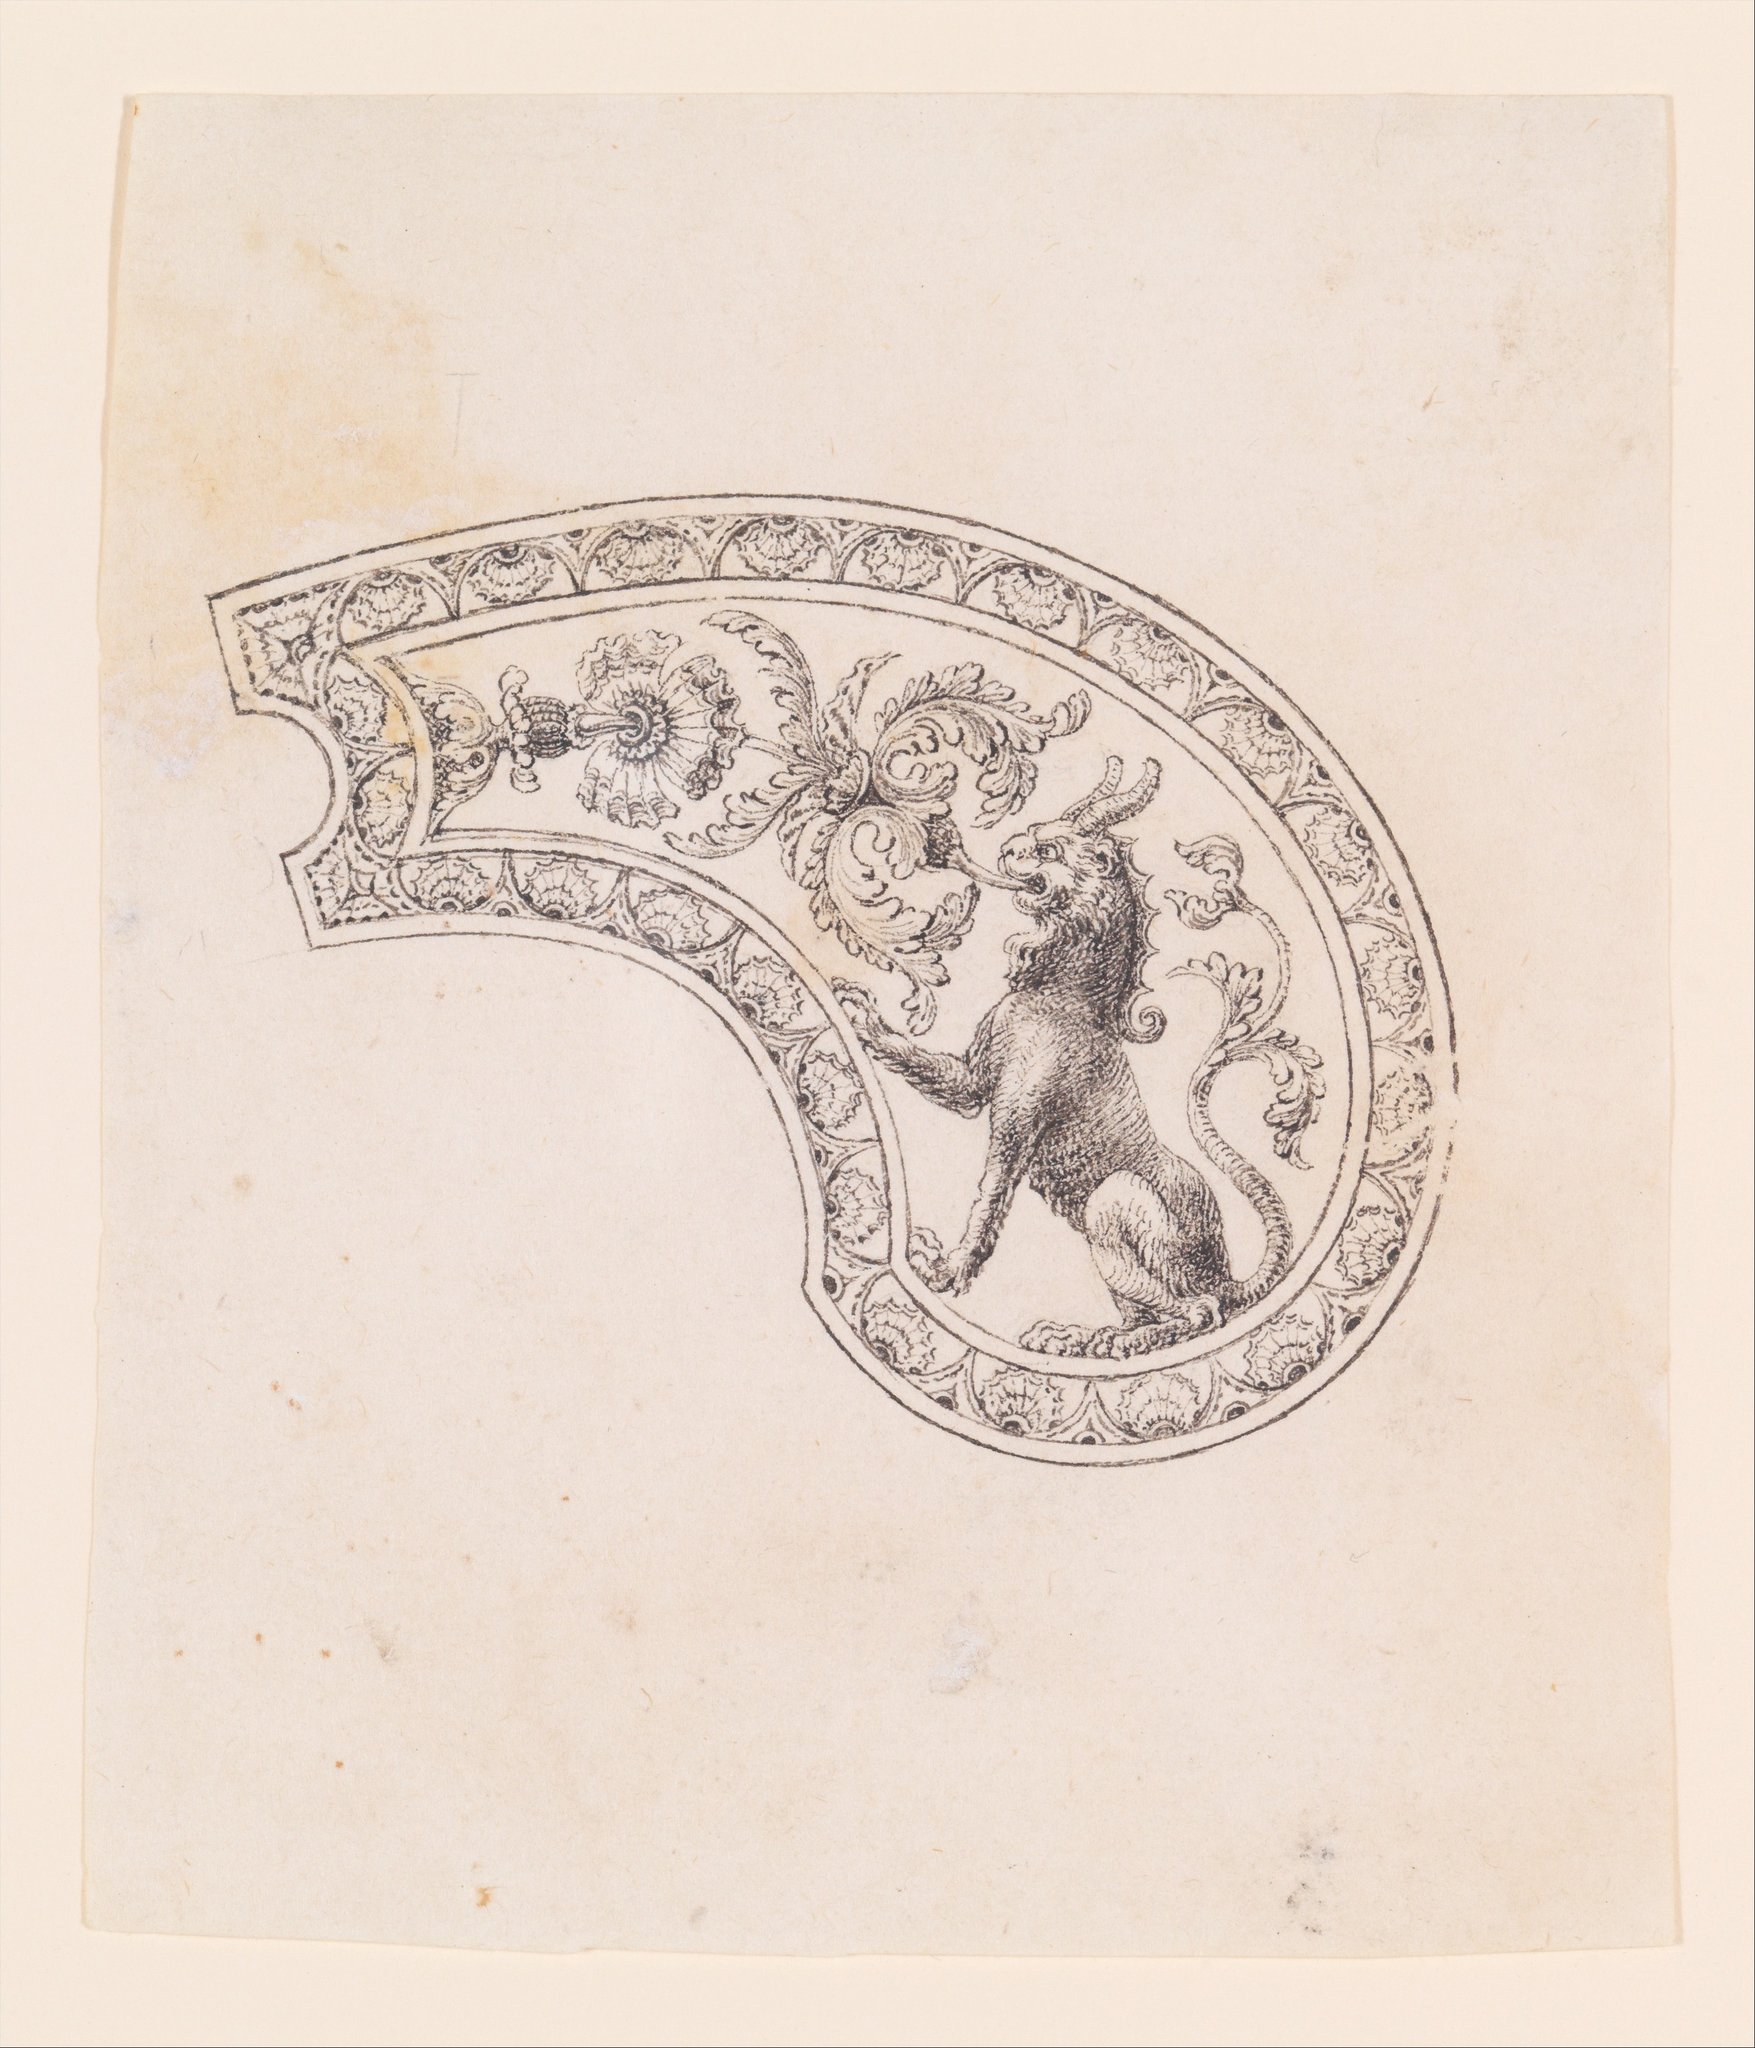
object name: drawing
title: Designs for the Decoration of Firearms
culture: french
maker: nicolas noël boutet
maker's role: designer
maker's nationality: french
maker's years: 1761-1833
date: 1795-1805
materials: ink, paper, pencil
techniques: wash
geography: france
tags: ornament